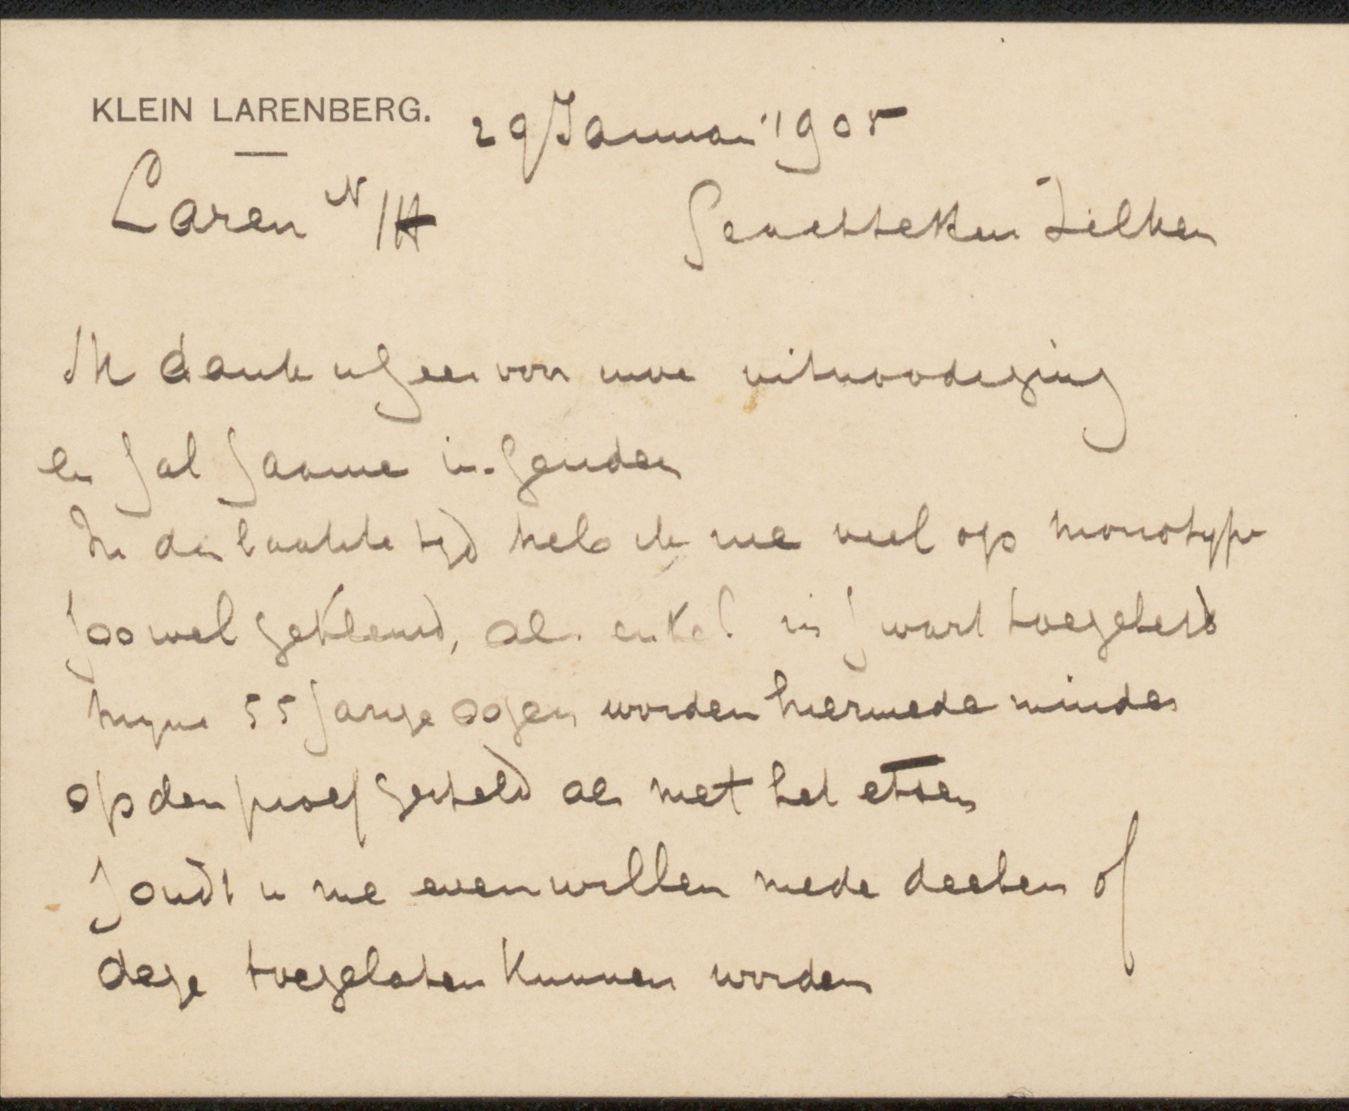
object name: letter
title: Brief aan Philip Zilcken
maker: elias stark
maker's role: draughtsman, print maker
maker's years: 1849-1933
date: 1905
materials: cardboard, ink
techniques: pen, printing, writing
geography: laren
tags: painter, philip zilcken, drawing, the graphic arts, amsterdam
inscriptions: collector's mark: ‘RPK’